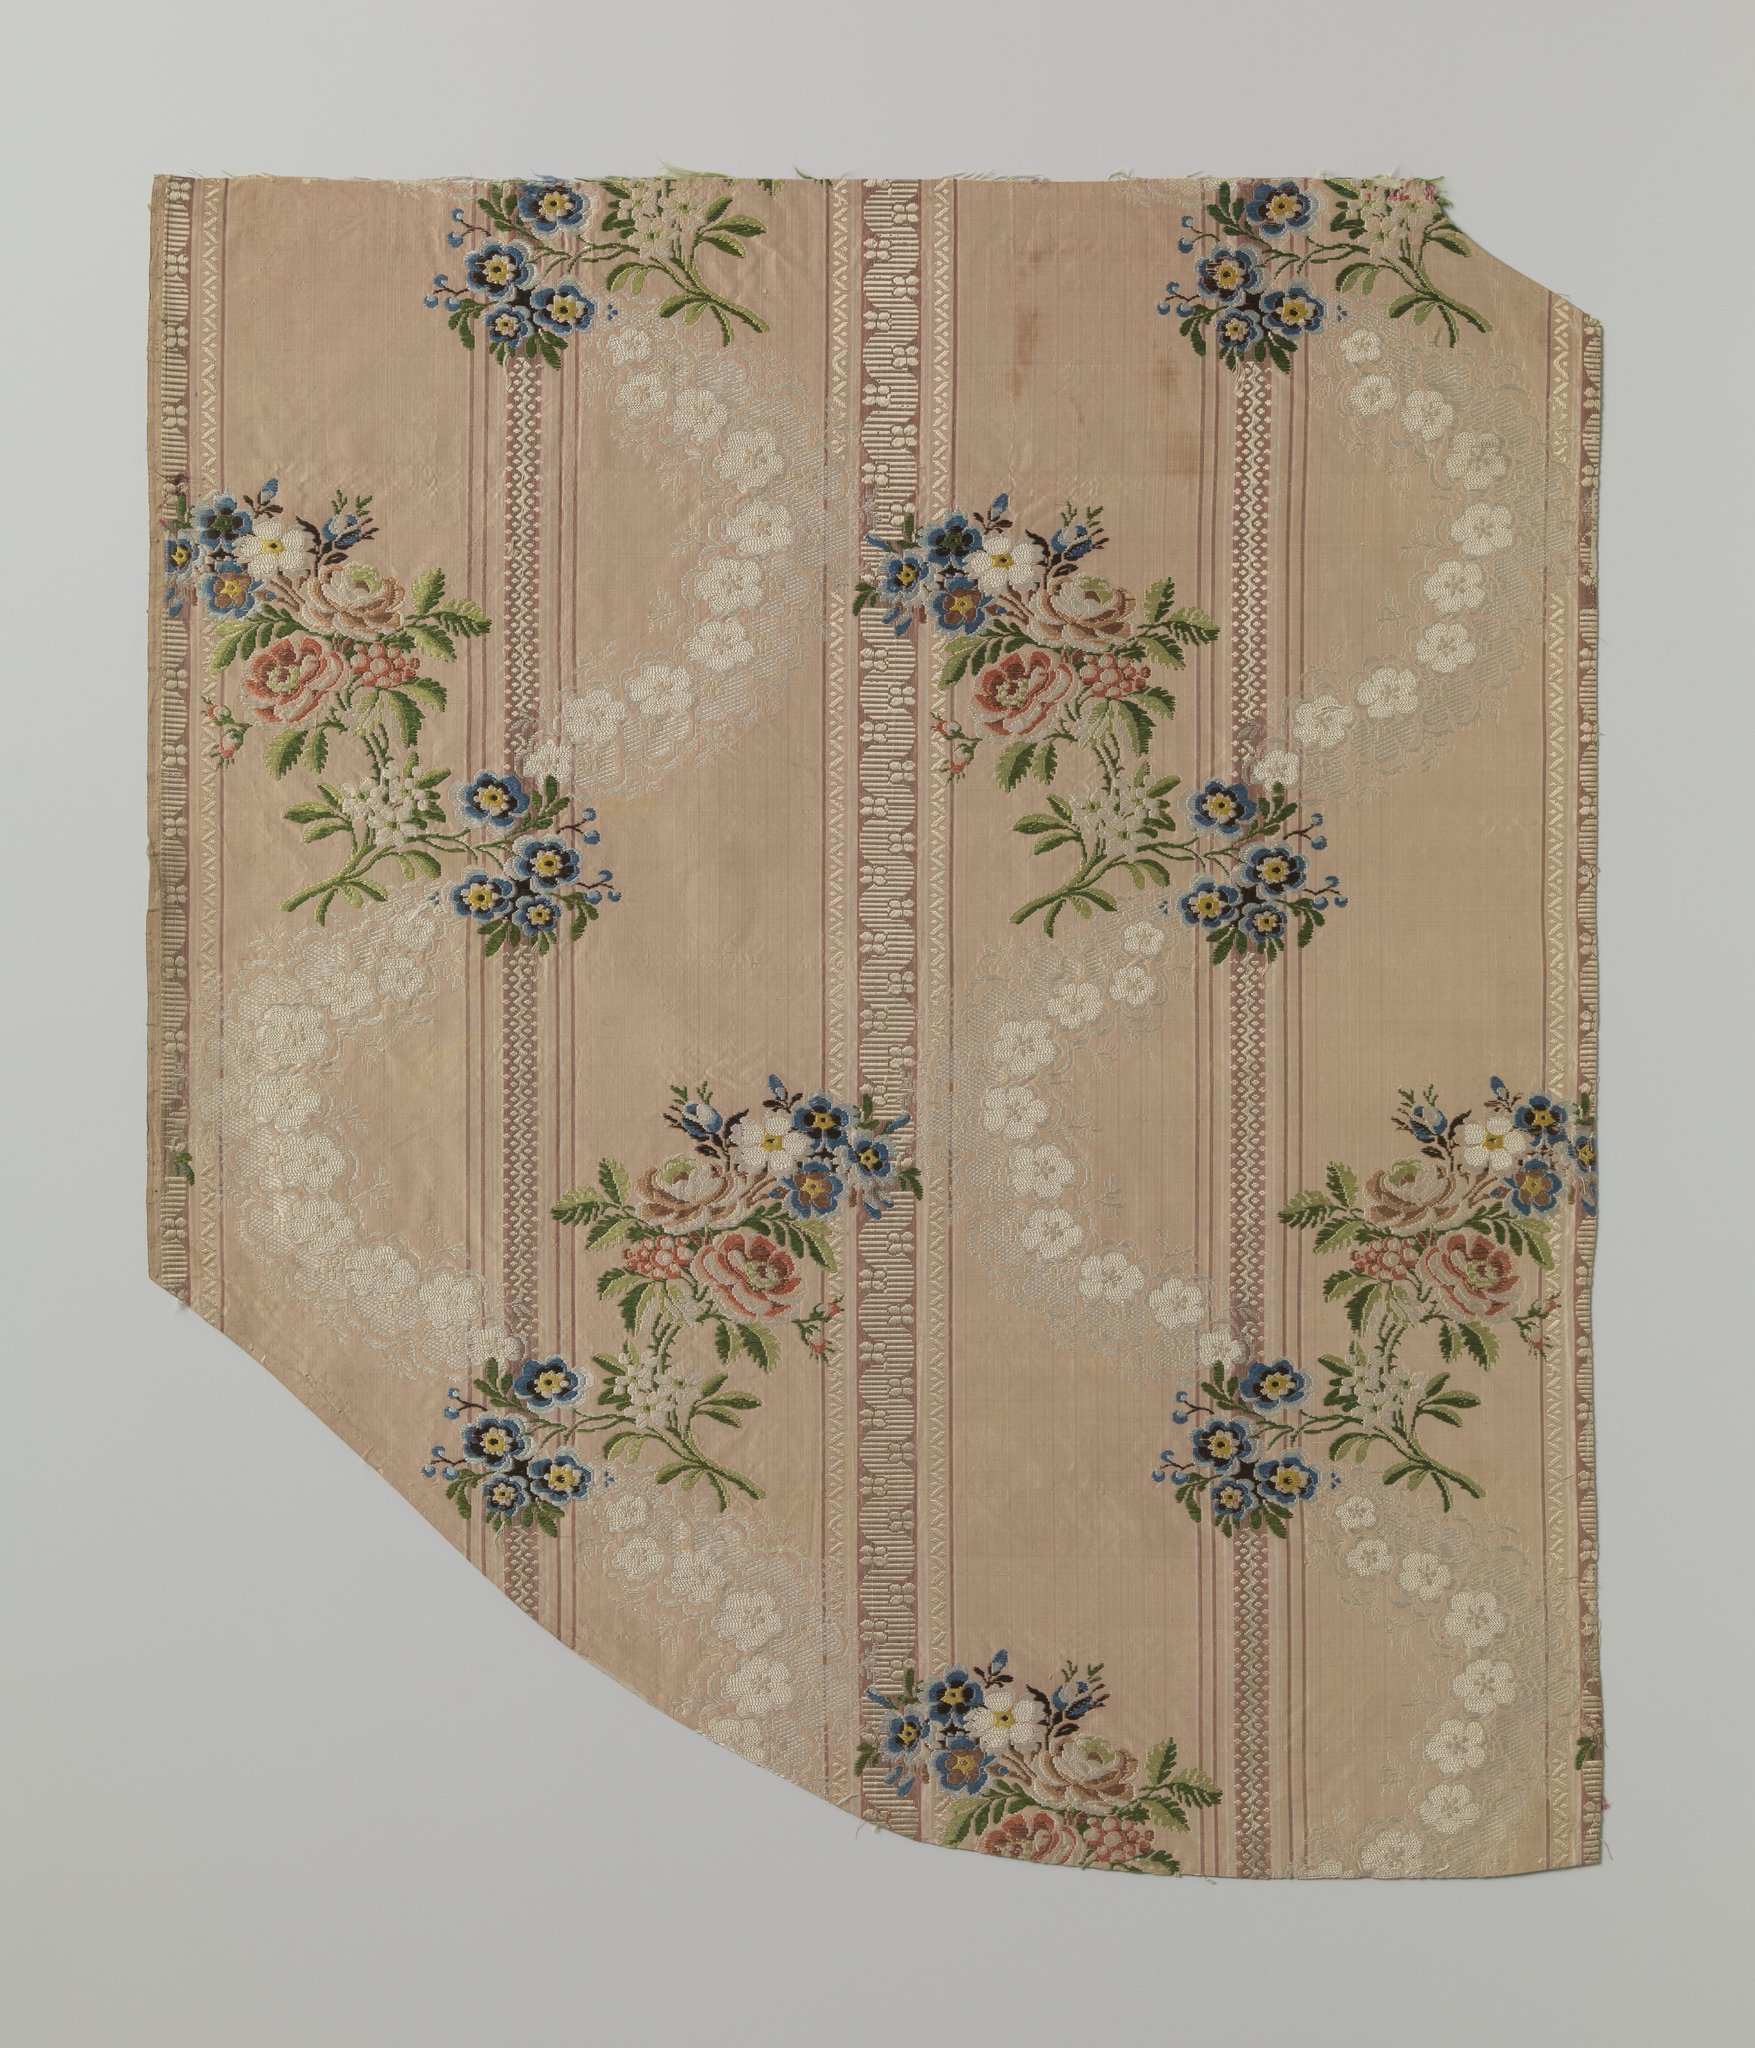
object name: fragment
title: Fragment veelkleurig zijdeweefsel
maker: Anonymous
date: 1750-1775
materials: silk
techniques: brocade, gadrooning, weave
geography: france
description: Een fragment. Grond van roze zijde met lichtere strepen, slingers van witte bloemen en gekleurde boeketten. Opmerking: De twee hoeken zijn afgesneden. Let op de regelmatige foutjes bij de blauwe bouquetjes (kan wijzen op Jacquardw).